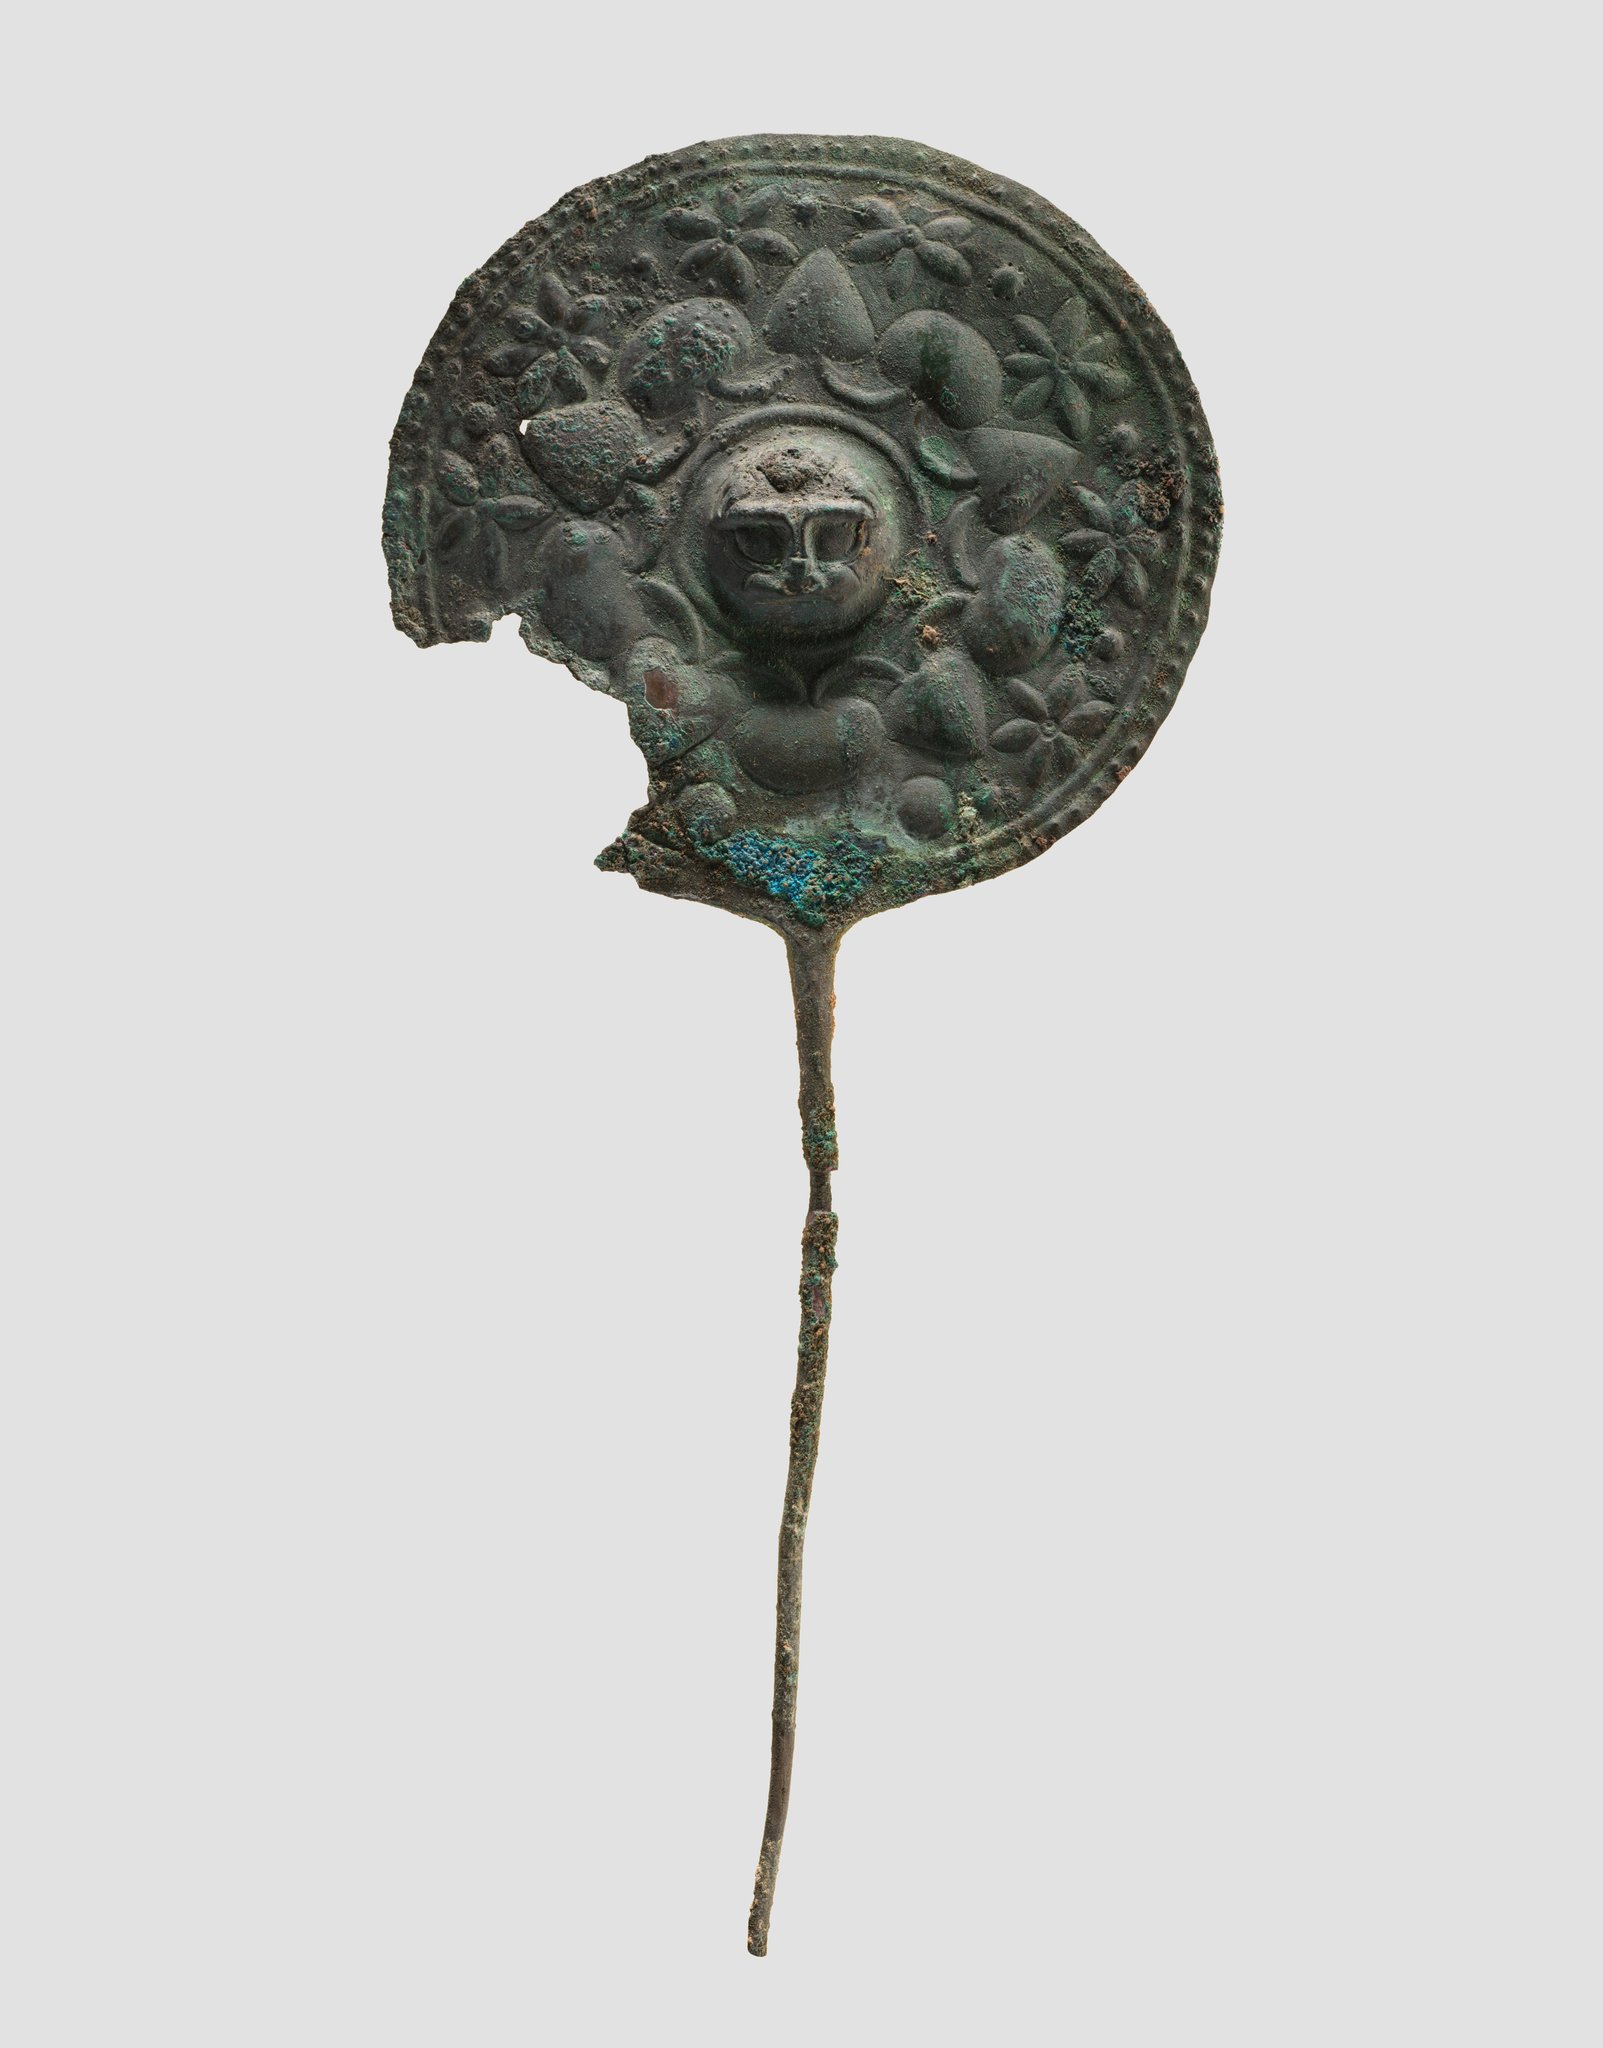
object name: pin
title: Disc-headed pin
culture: iranian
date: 800-601 BCE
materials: bronze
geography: iran, luristan